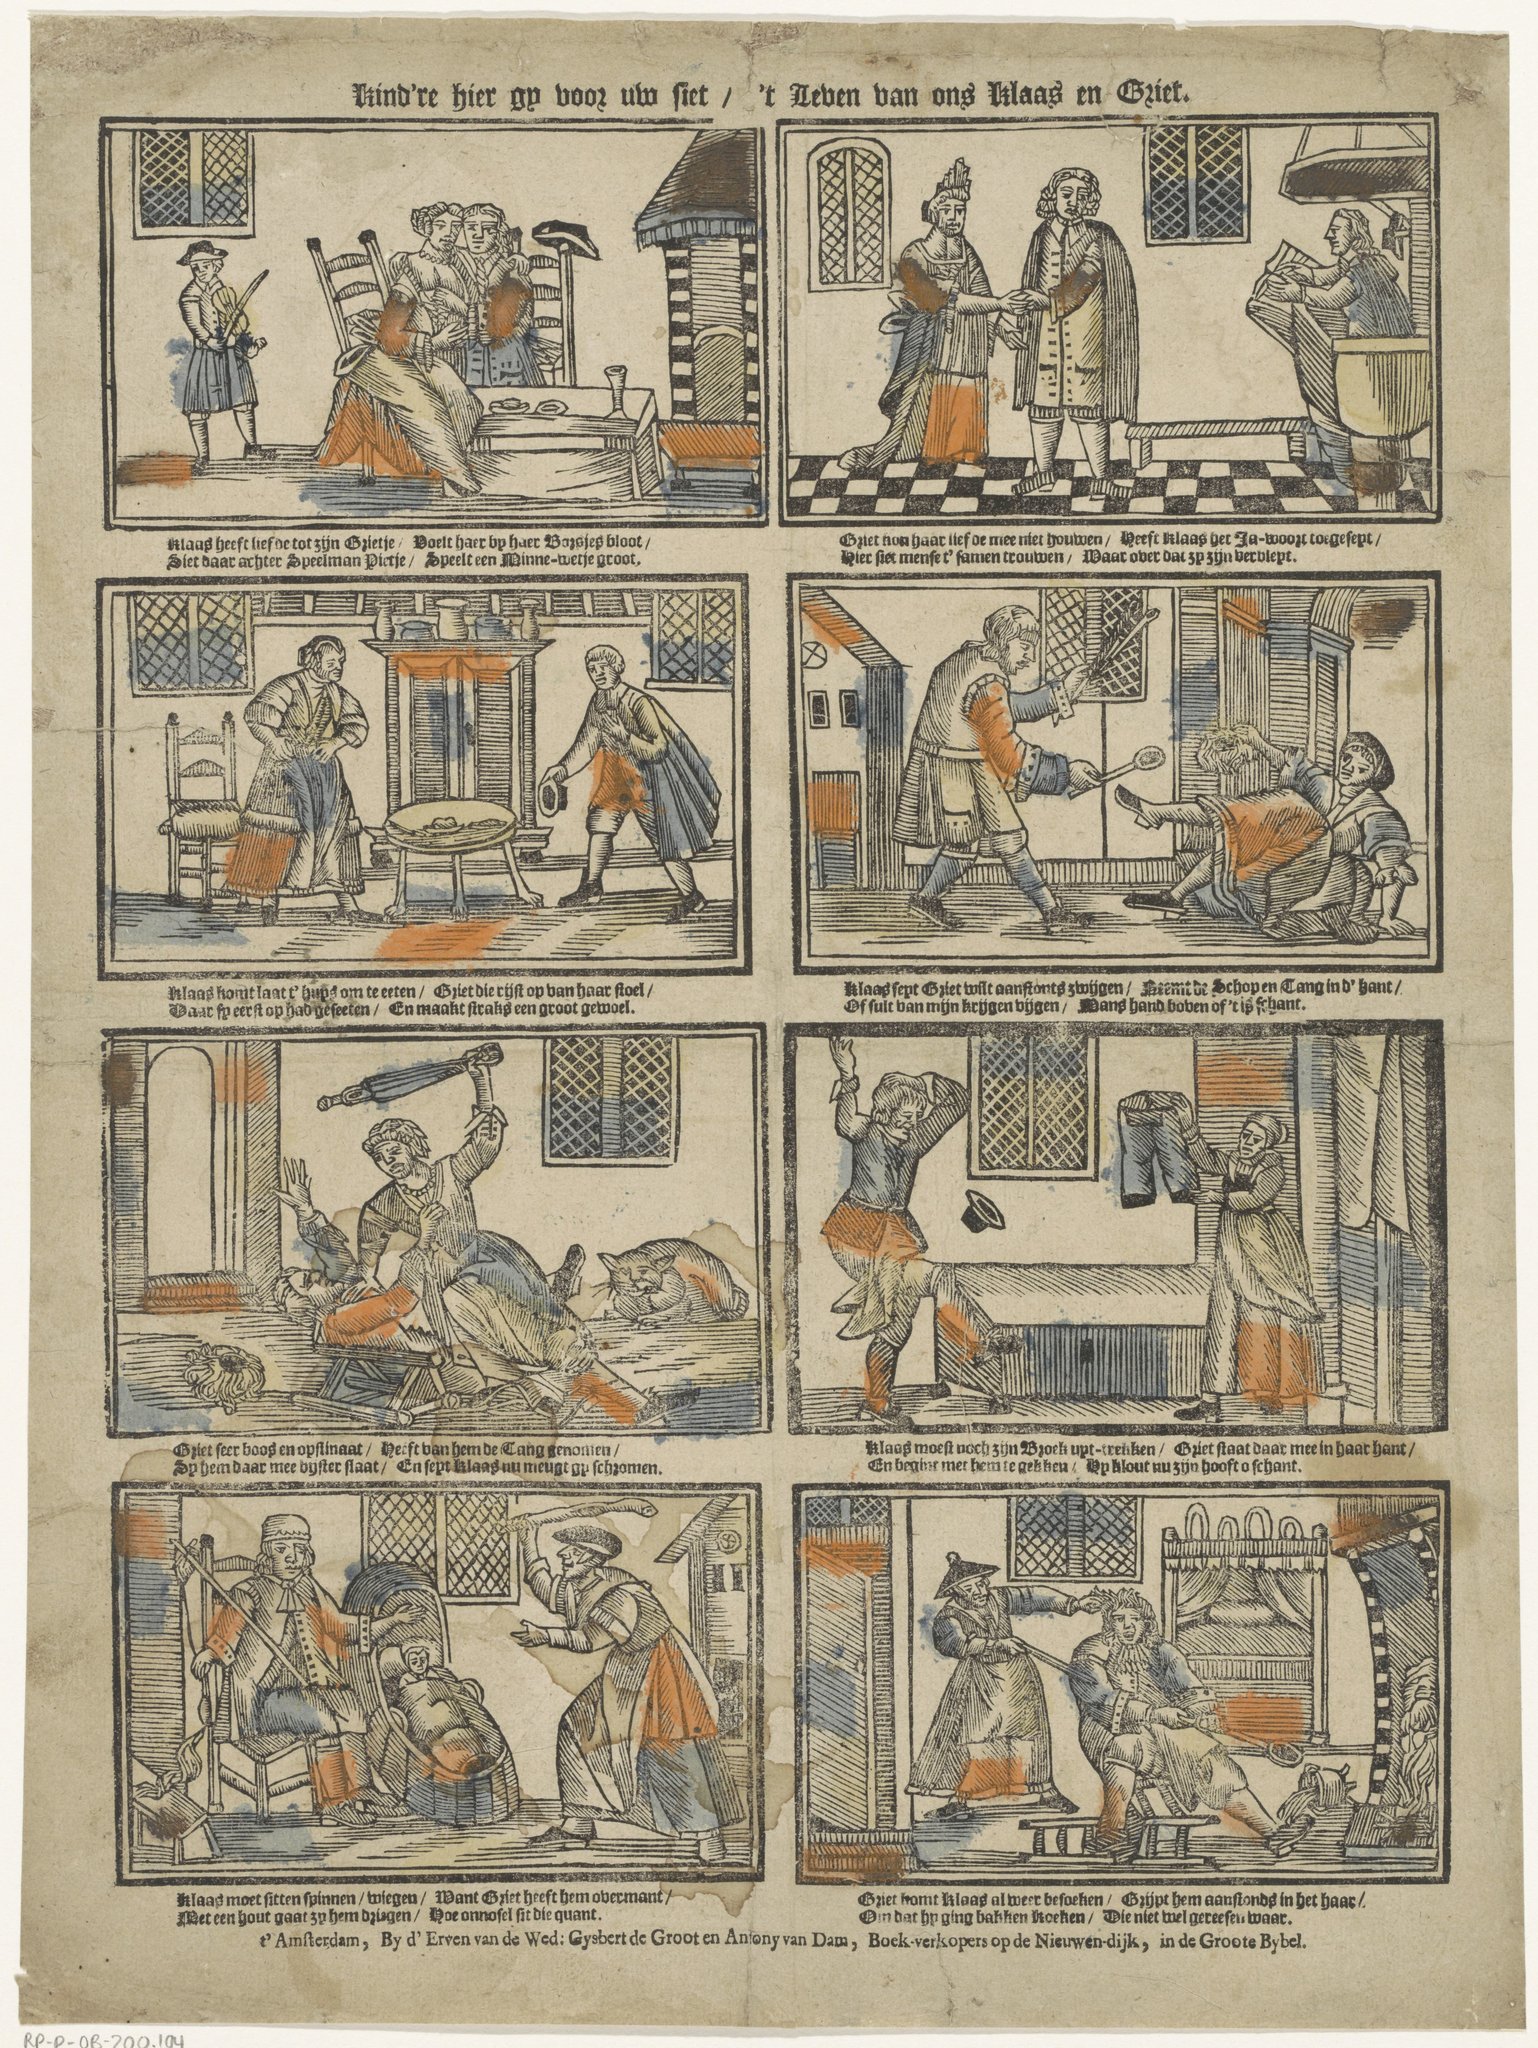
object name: print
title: Kind're hier gy voor uw siet / 't leven van ons Klaas en Griet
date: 1719-1724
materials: paper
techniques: colour, letterpress printing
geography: amsterdam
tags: hen-pecked husband, 'betty', 'molly' (man who engages in women's work)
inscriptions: collector's mark: Lugt 2760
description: Blad met 8 voorstellingen over het leven van Klaas en Griet, en de strijd om de broek. Onder elke afbeelding een tweeregelig vers.